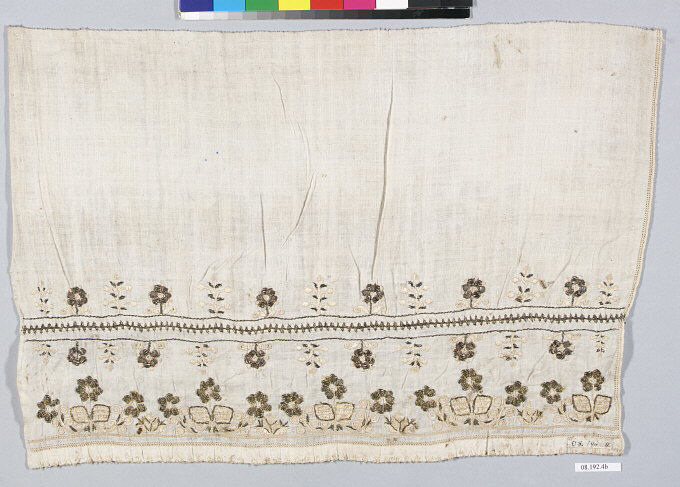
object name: cover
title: End of a cover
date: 1801-1900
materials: linen, silk